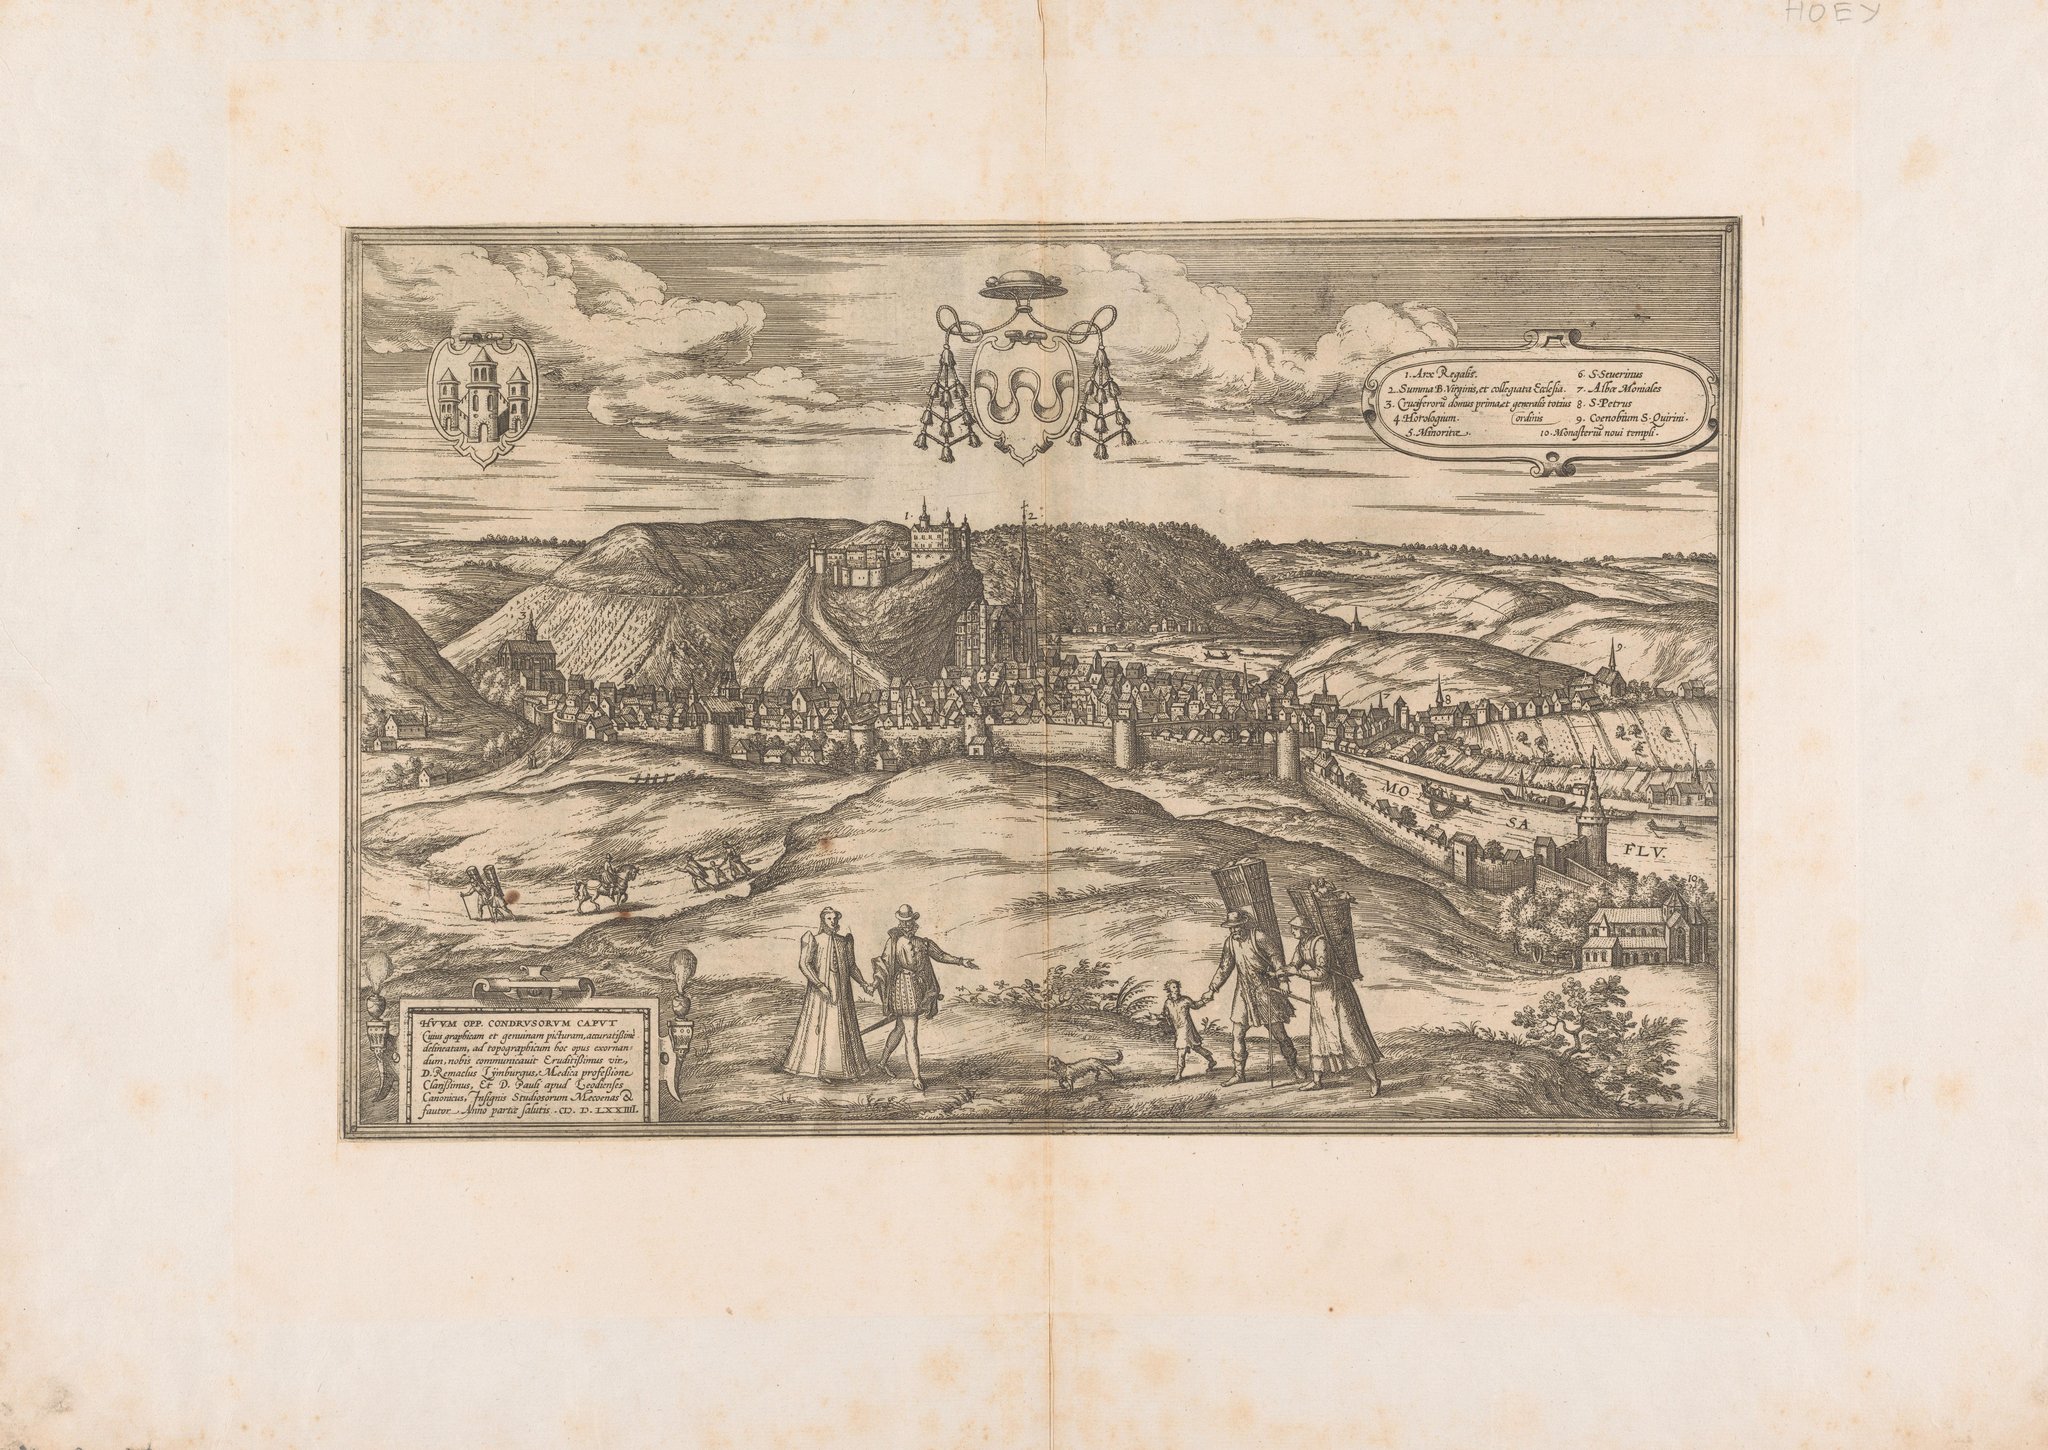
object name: book illustration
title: Gezicht op Hoei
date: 1588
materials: paper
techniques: etching, letterpress printing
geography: cologne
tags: city-view in general; 'veduta'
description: Prent opgenomen in: Braun, Georg. Civitates orbis terrarum, 6 dln. Keulen: Peter von Brachel en Gottfried von Kempen, 1572-1618, dl. IV (1588).